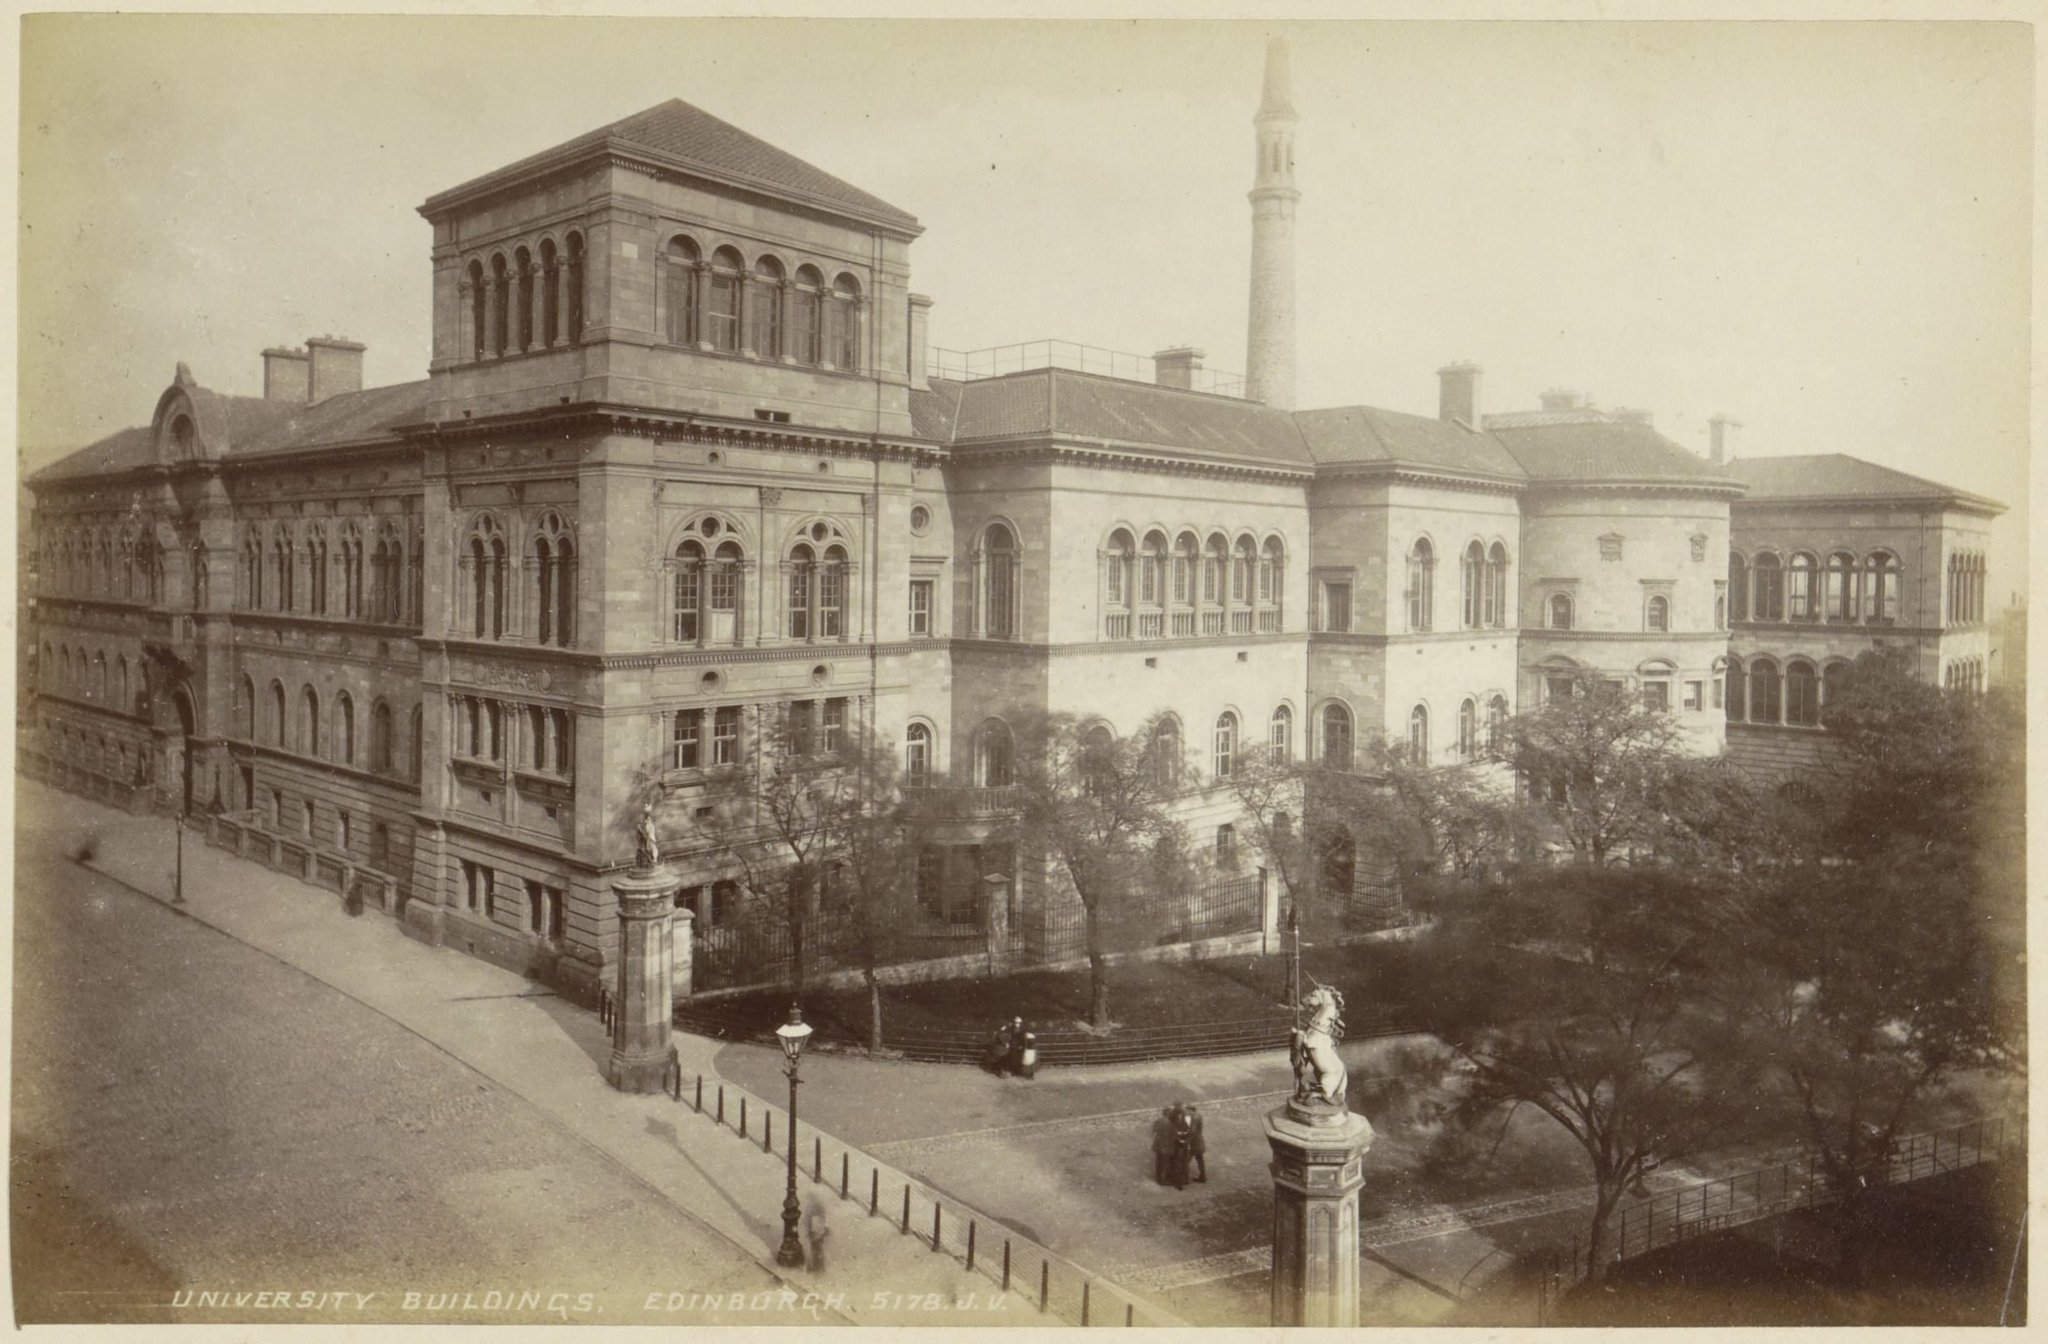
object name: photograph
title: Exterieur van universiteitsgebouwen in Edinburgh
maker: james valentine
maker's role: fotograaf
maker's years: 1815-1880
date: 1870-1890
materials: cardboard, photographic support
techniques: albumen print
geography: edinburgh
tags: university building, college, prospect of city, town panorama, silhouette of city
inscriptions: number: ‘5178’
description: Onderdeel van Fotoalbum met bezienswaardigheden in Edinburgh en Londen.